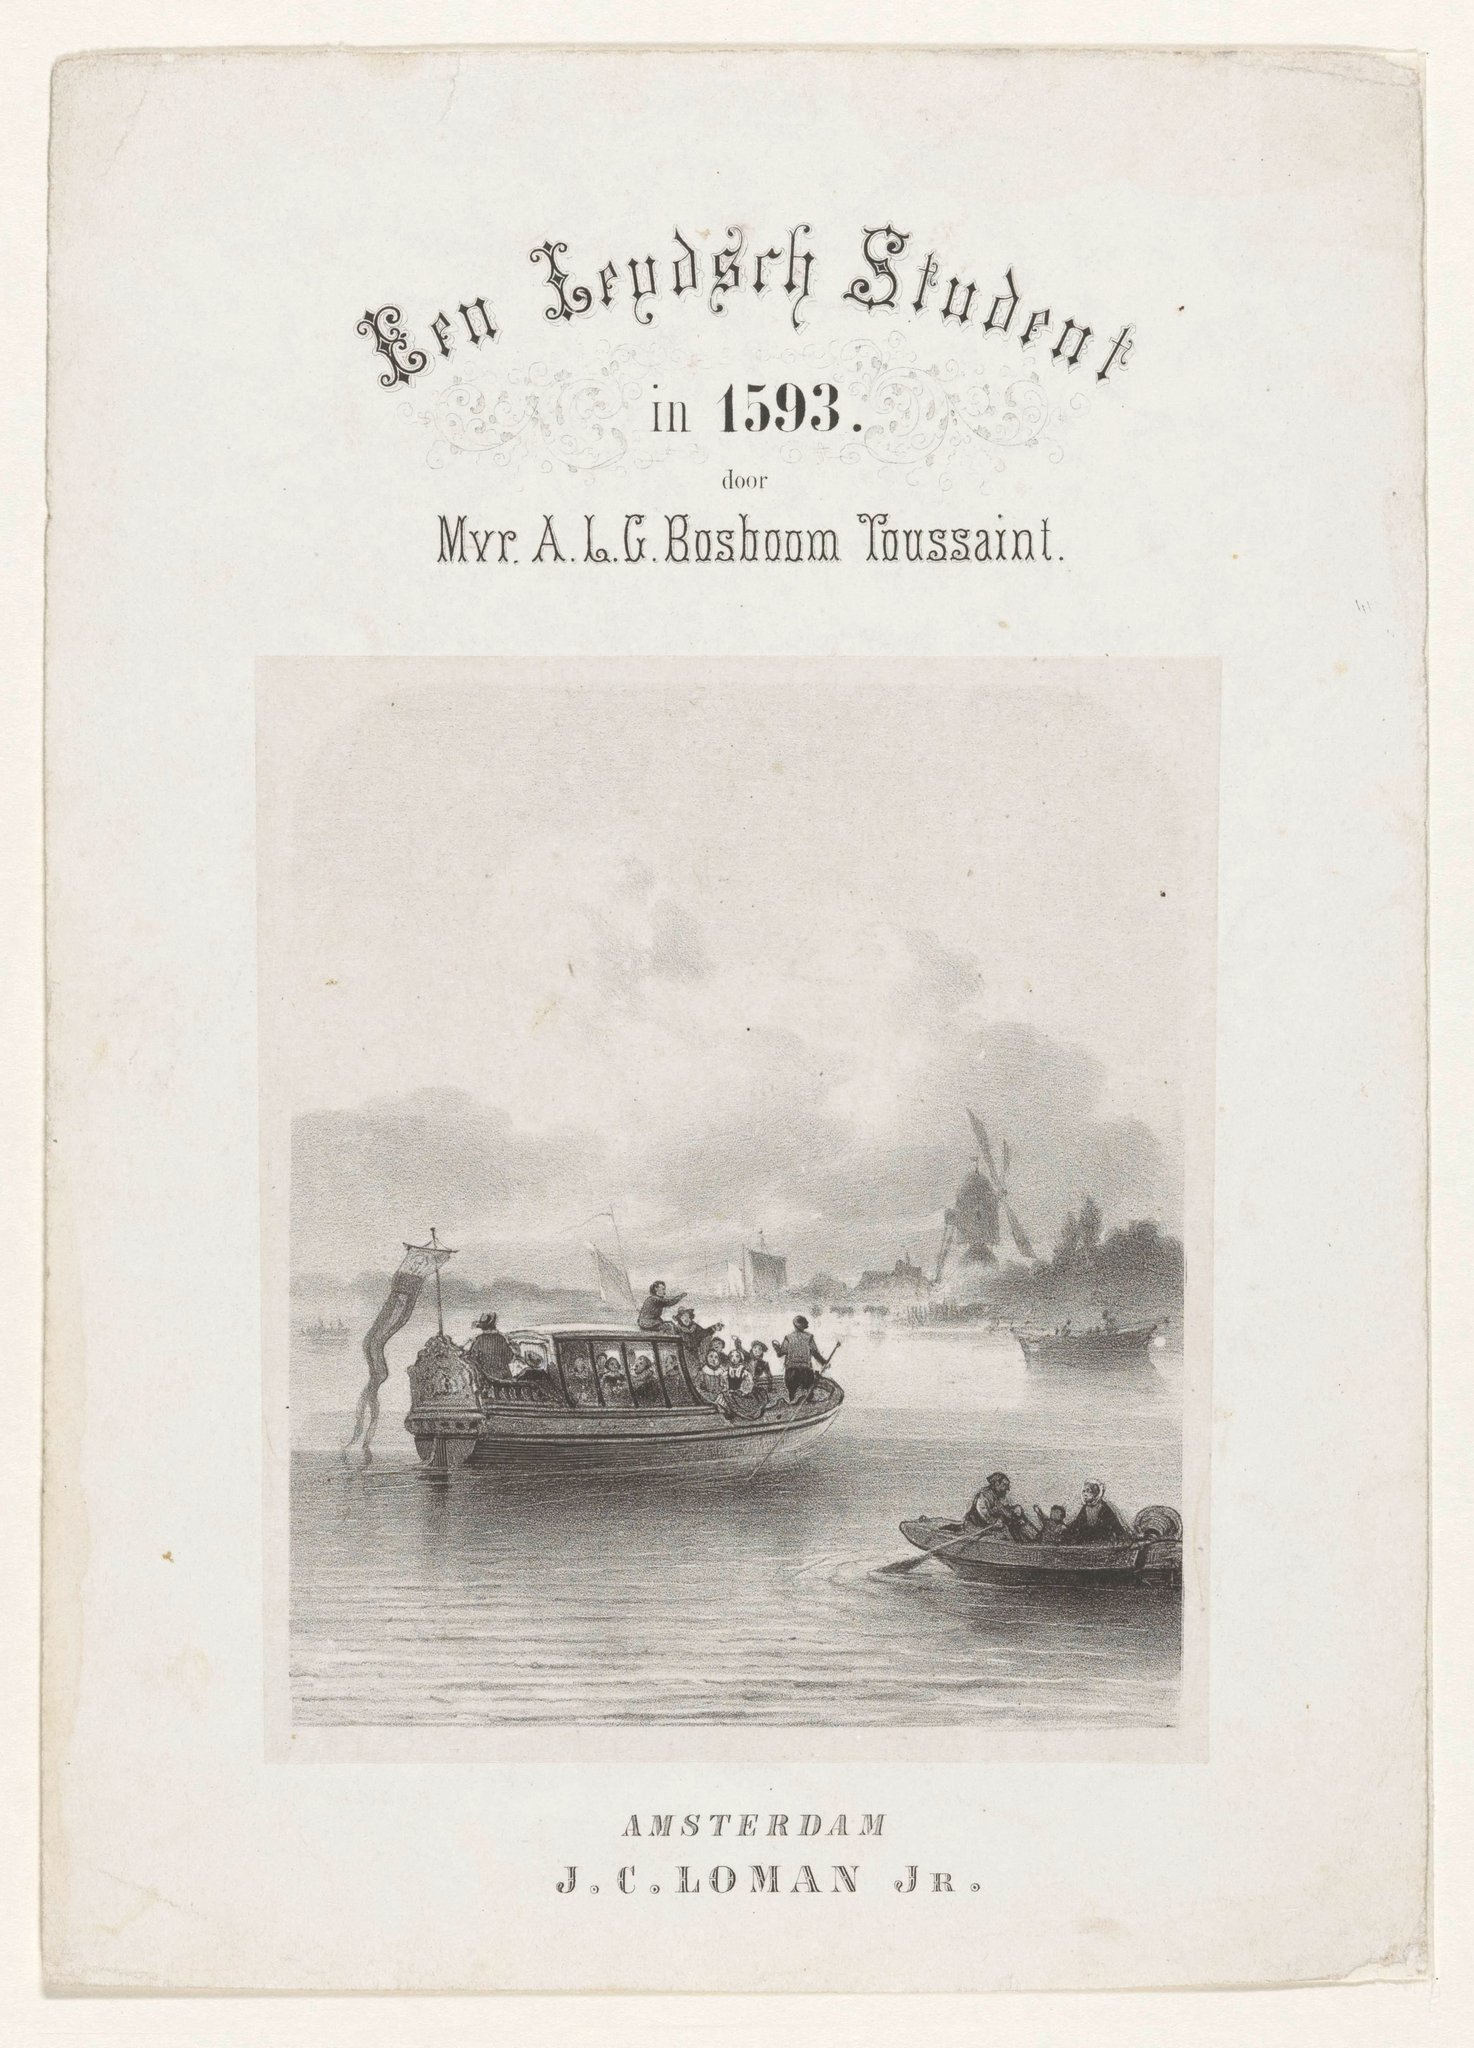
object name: titelblad, titelpagina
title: Boten op het water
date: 1858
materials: paper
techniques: lithograph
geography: amsterdam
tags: rowing-boat, canoe, etc.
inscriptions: collector's mark: Lugt 2228, collector's mark: Lugt 2760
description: Titelpagina voor: Bosboom Toussaint, A.L.G. Een Leydsch Student in 1593. Amsterdam: Loman, J.C. (Junior), 1858. Titelpagina voor een boek over Floris II van Pallandt als student te Leiden.